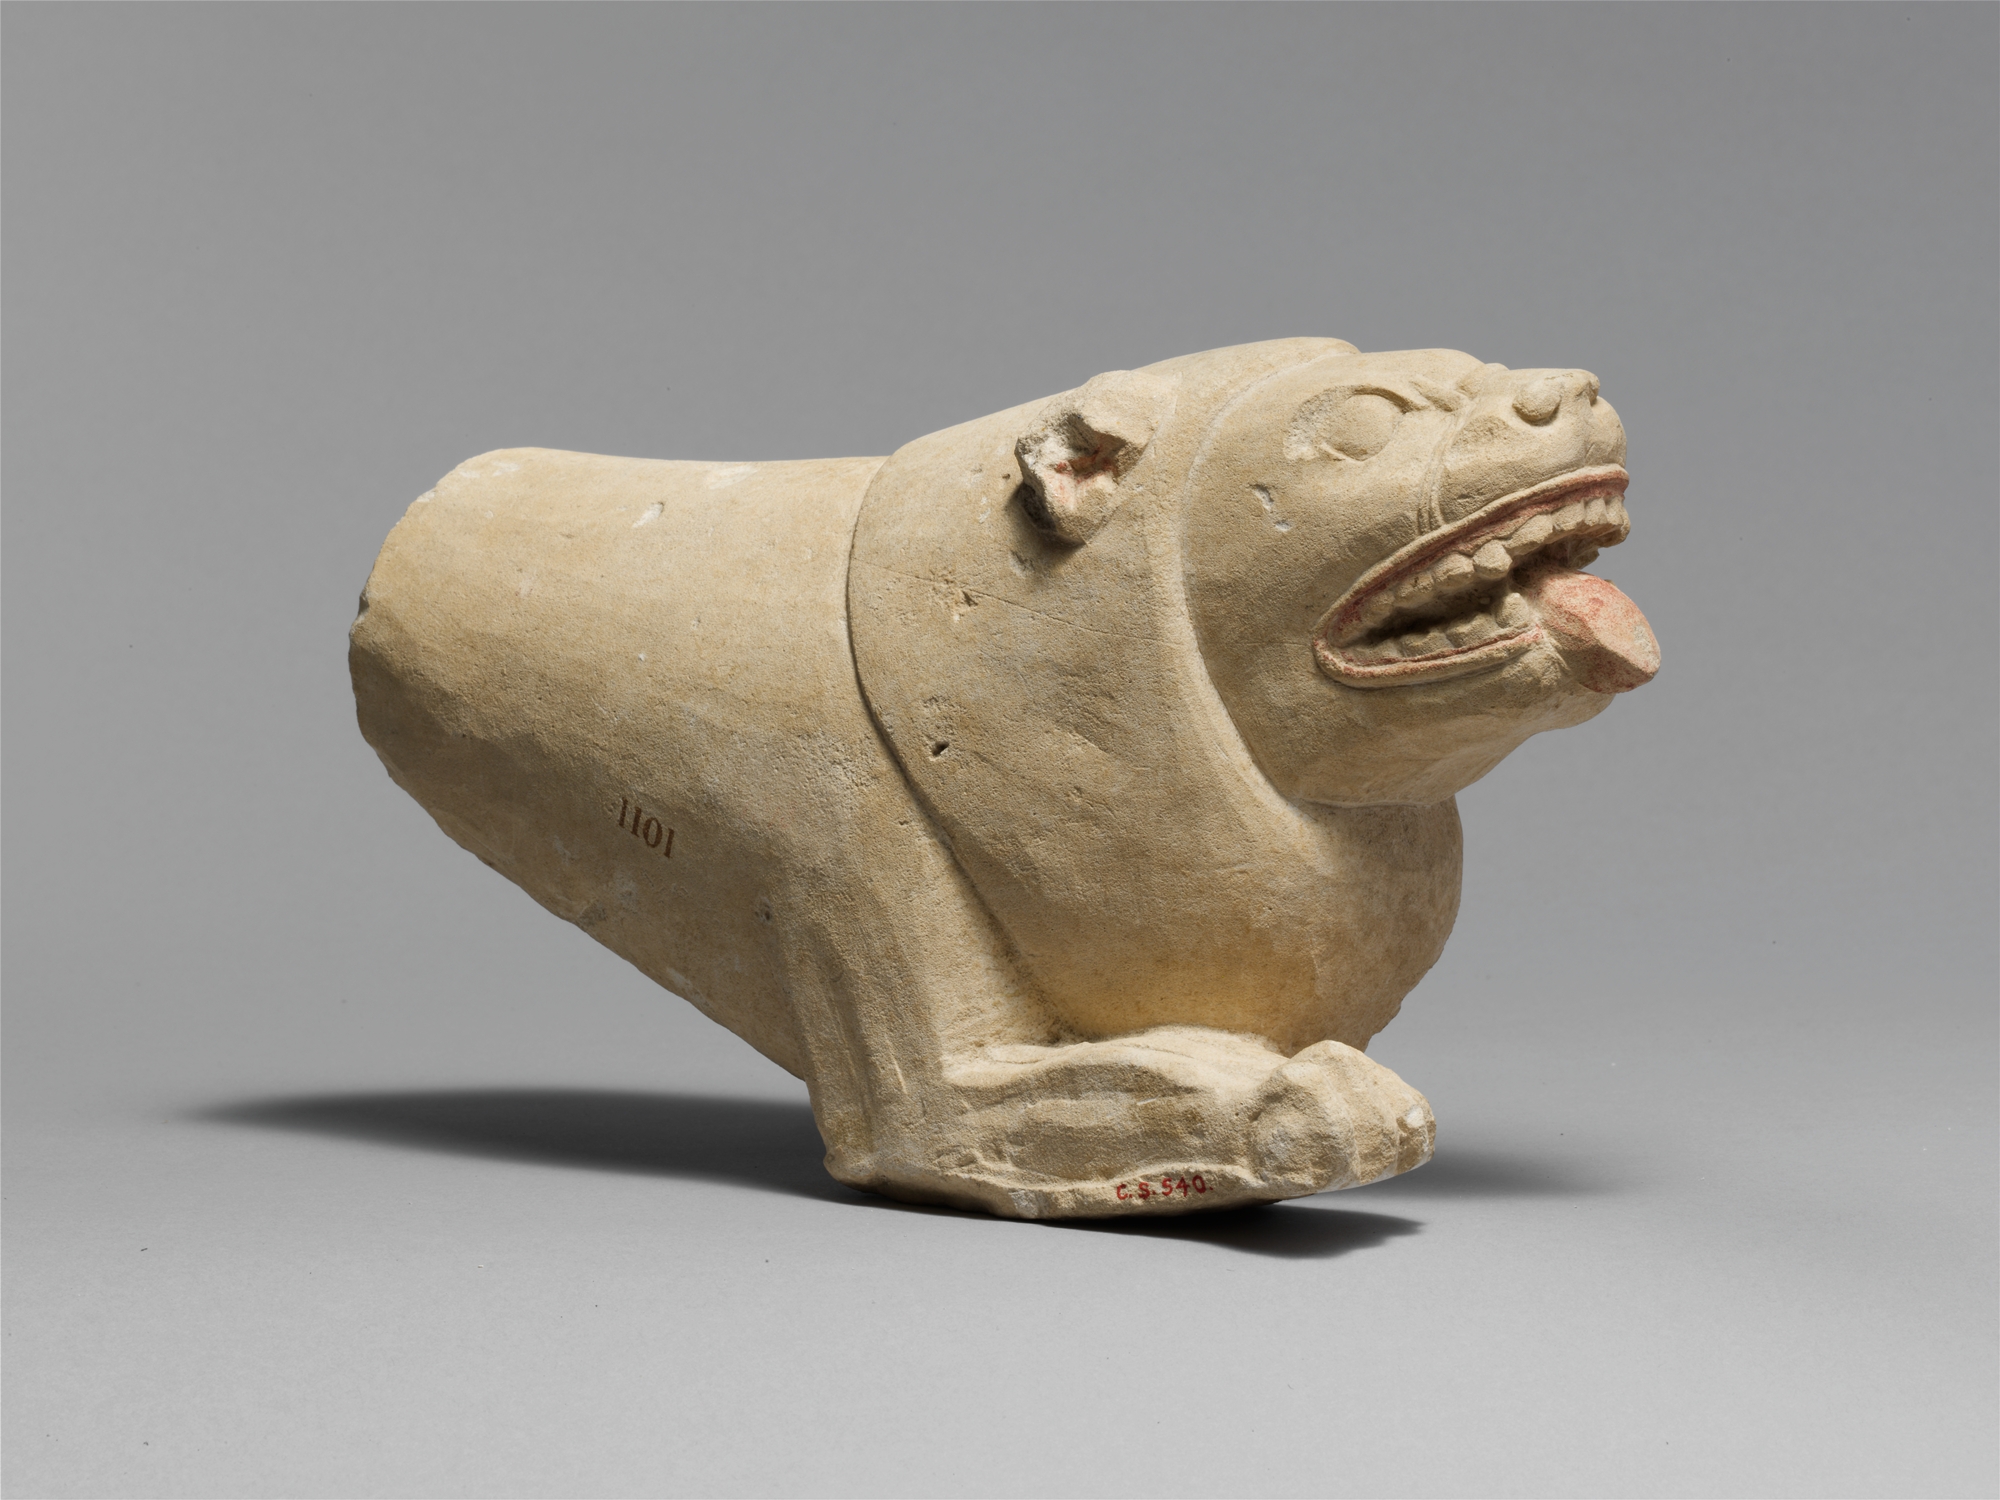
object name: statuette of a lion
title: Limestone statue of a lion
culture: cypriot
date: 700-650 BCE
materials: limestone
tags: lions